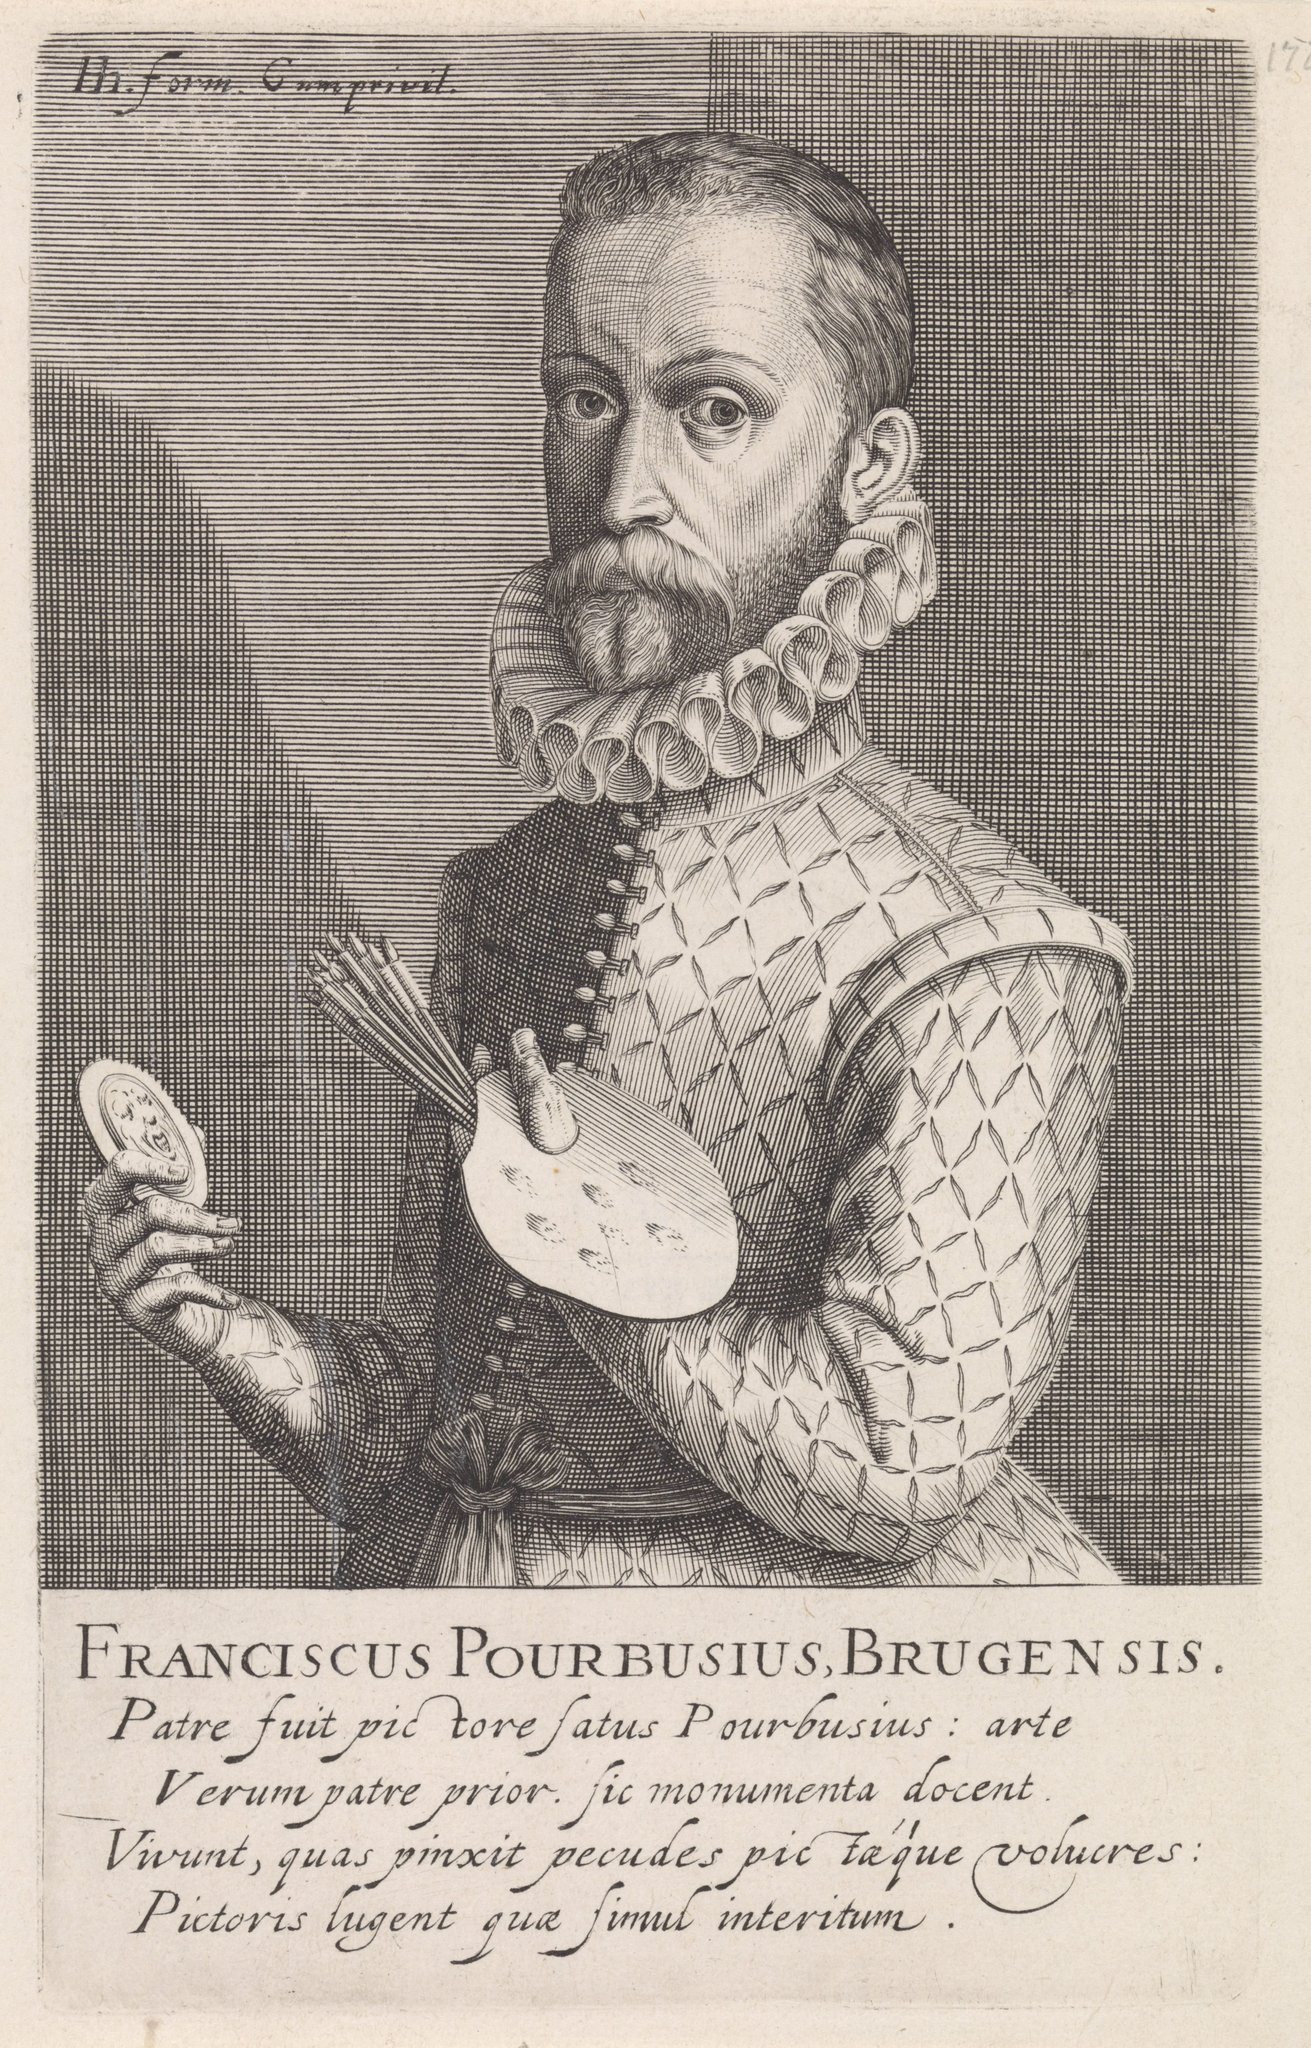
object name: print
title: Pictorum aliquot celebrium praecipuae Germaniae Inferioris effigies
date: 1610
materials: paper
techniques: engraving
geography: the hague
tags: bruges, antwerp, painter, frans pourbus (i), portrait, self-portrait of painter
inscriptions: collector's mark: Lugt 2228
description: Portret ten halven lijve naar links van Frans Pourbus I. Onder het portret zijn naam en vier regels in het Latijn. Prent uit deel 3 van de serie Pictorum Aliquot Celebrium Praecipuae Germaniae Inferioris Effigies. Serie van 72 kunstenaarsportretten vervaardigd door Hendrick Hondius I, Simon Frisius, Andries Jacobsz. Stock en Robert de Baudous.